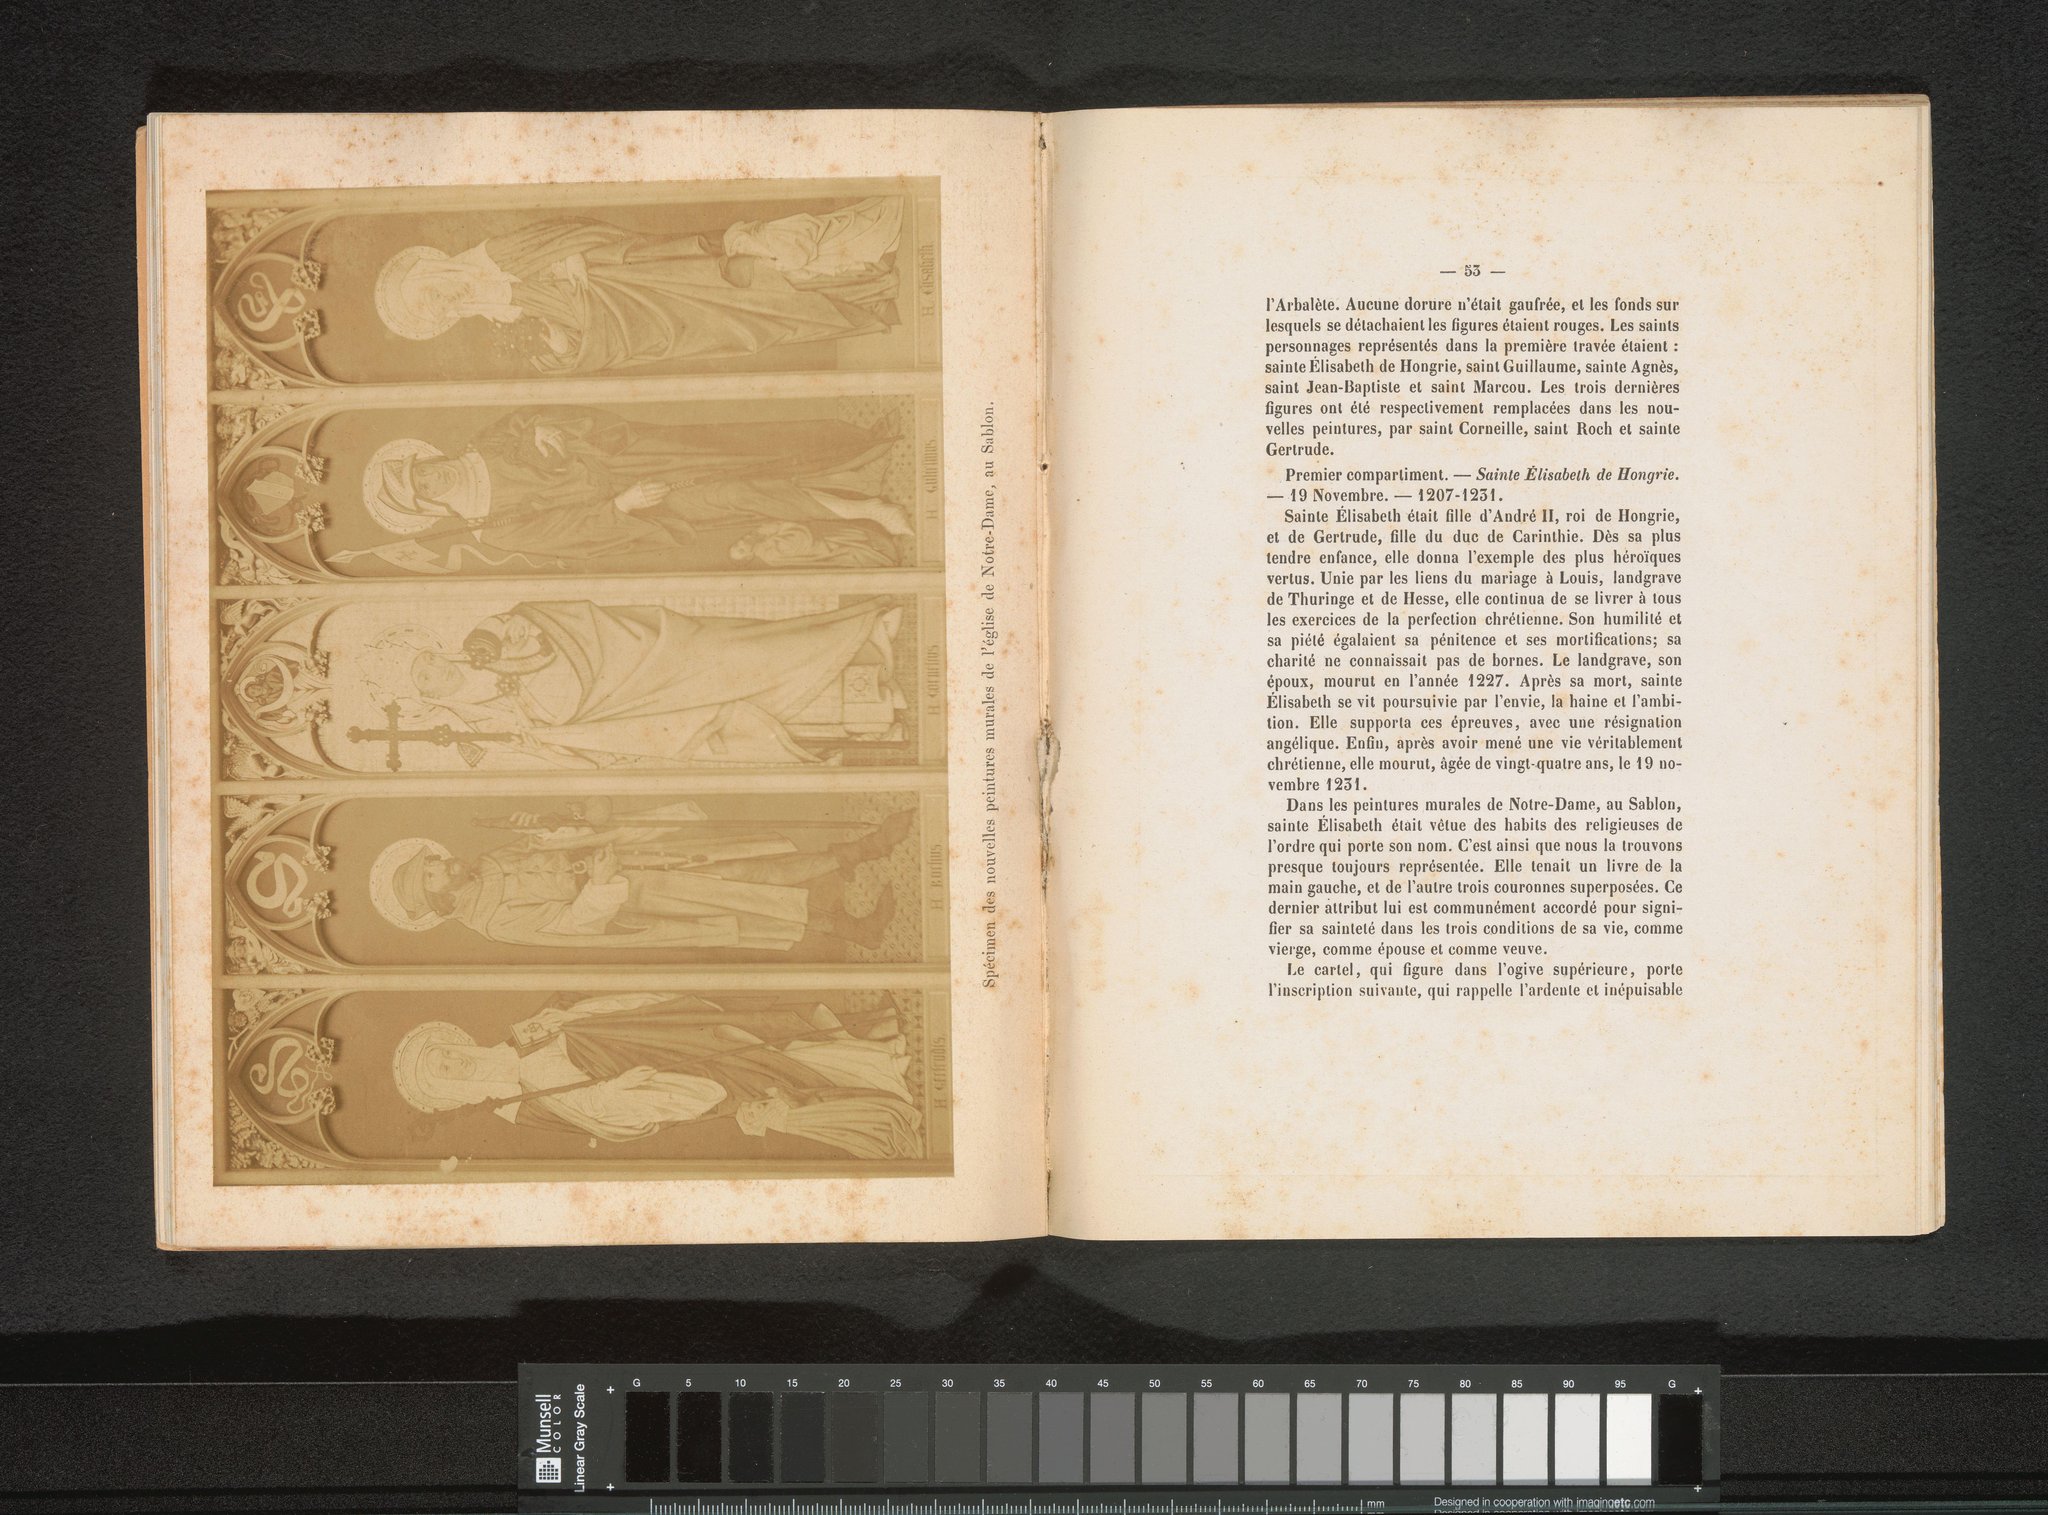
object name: photograph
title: Spécimen des nouvelles peintures murales de l'eglise de Notre-Dame, au Sablon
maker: Anonymous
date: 1863-1868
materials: photographic support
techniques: albumen print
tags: picture, painting